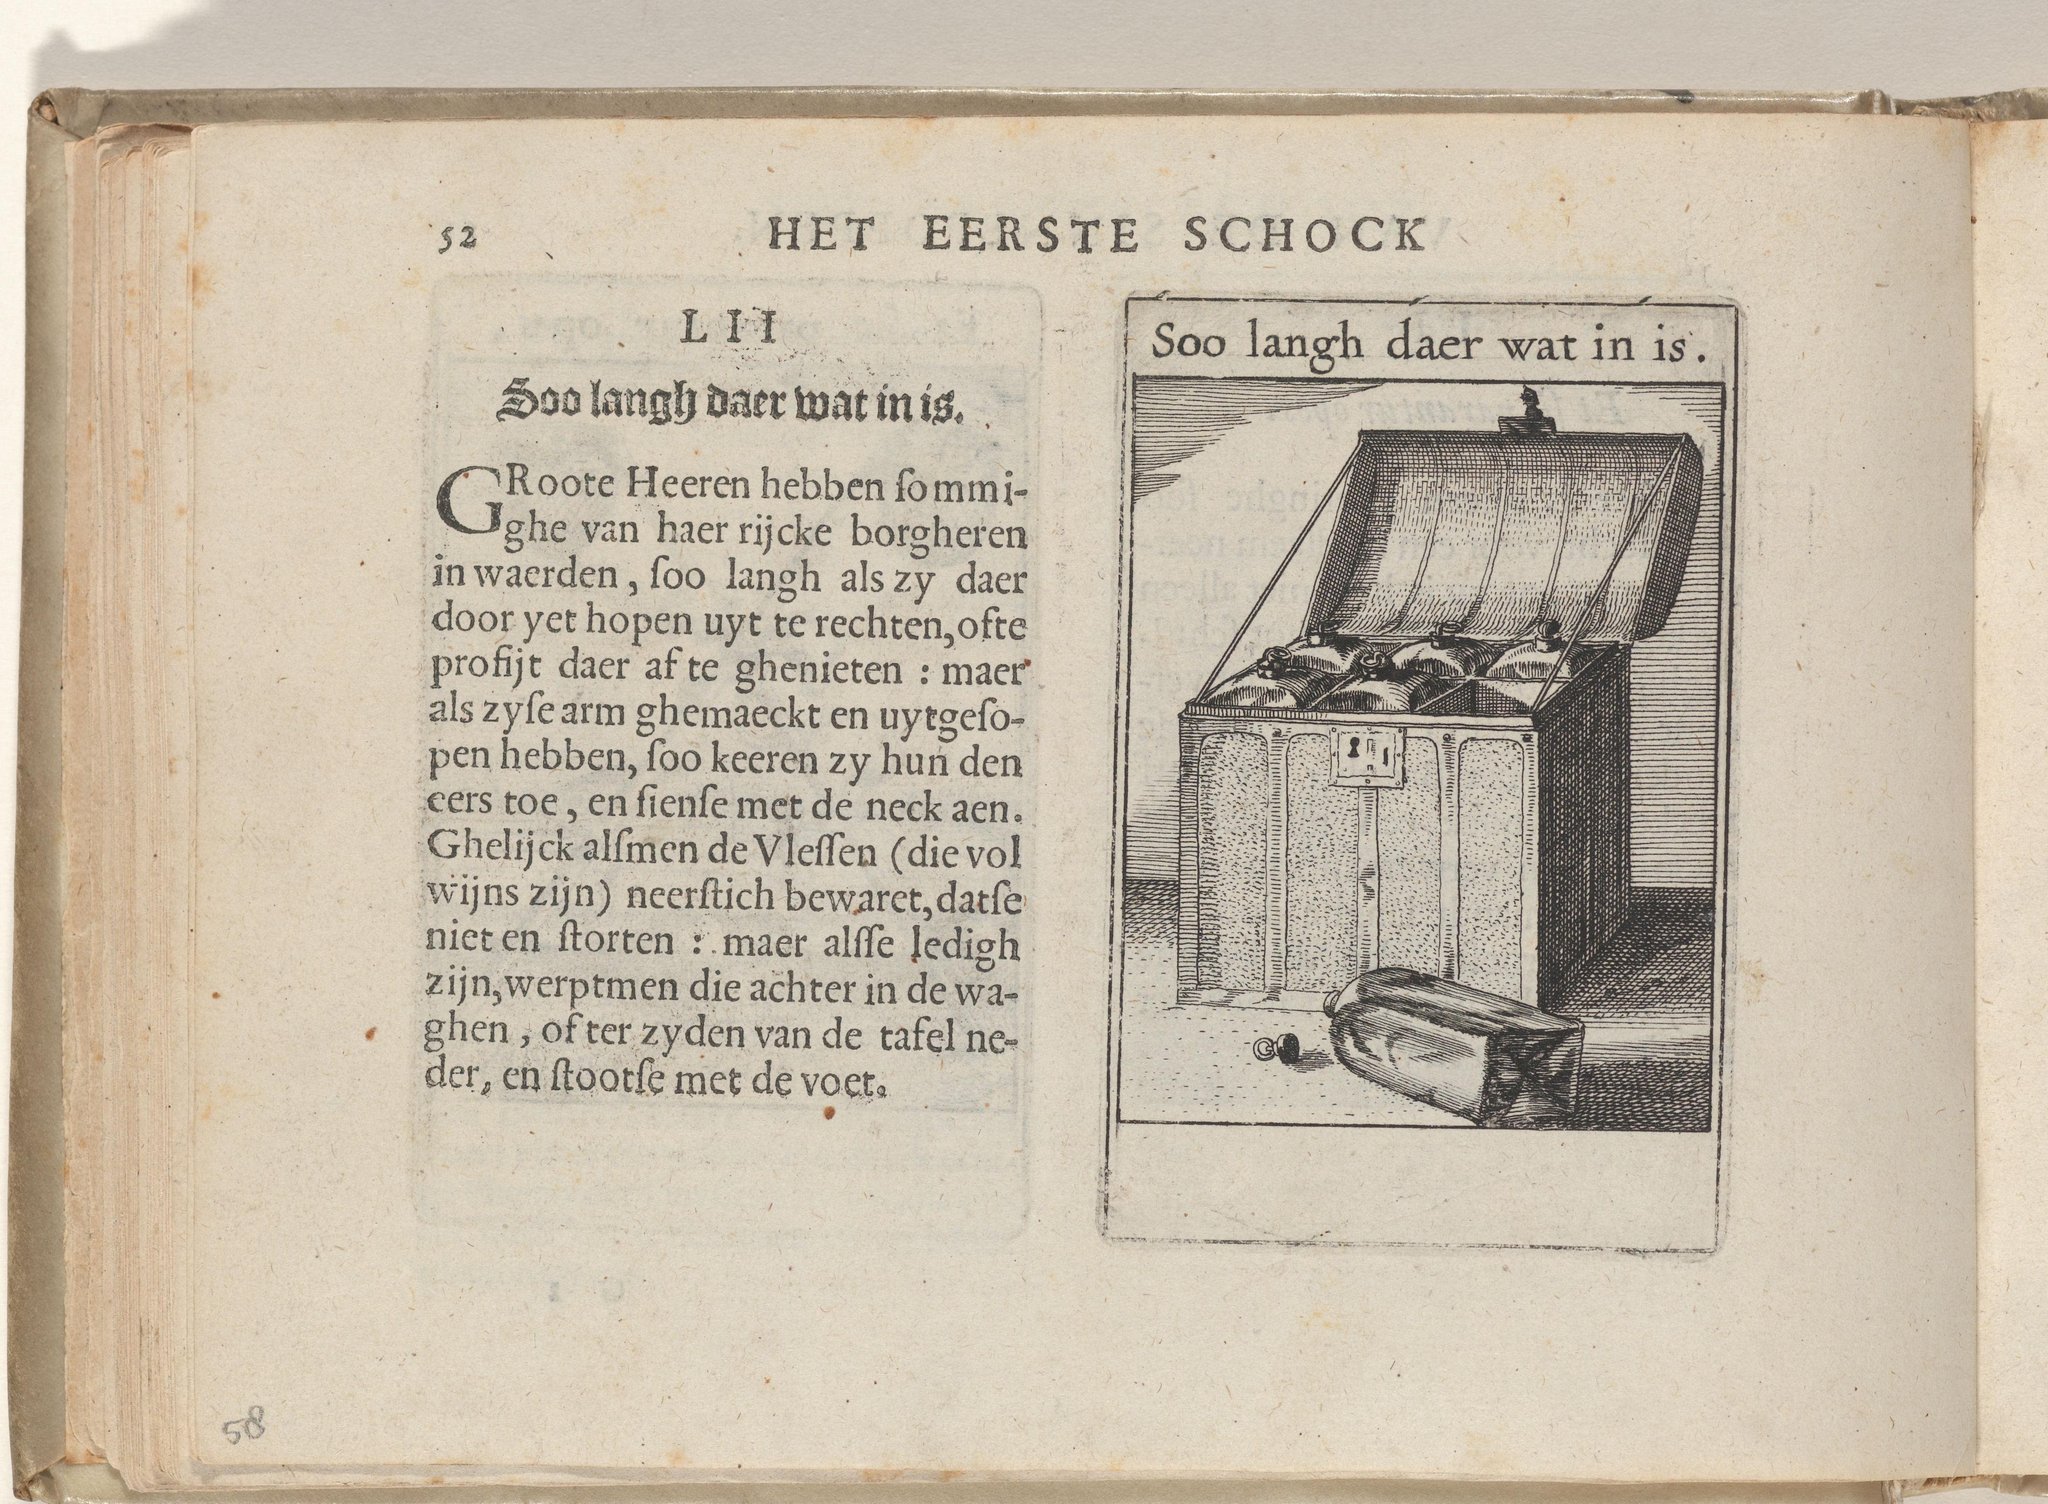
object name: print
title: LII Soo langh daer wat in is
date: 1614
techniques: engraving, printing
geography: the hague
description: LII Soo langh daer wat in is. Eerste schok. Onderdeel van 'Sinnepoppen', R. Visscher, 1614.